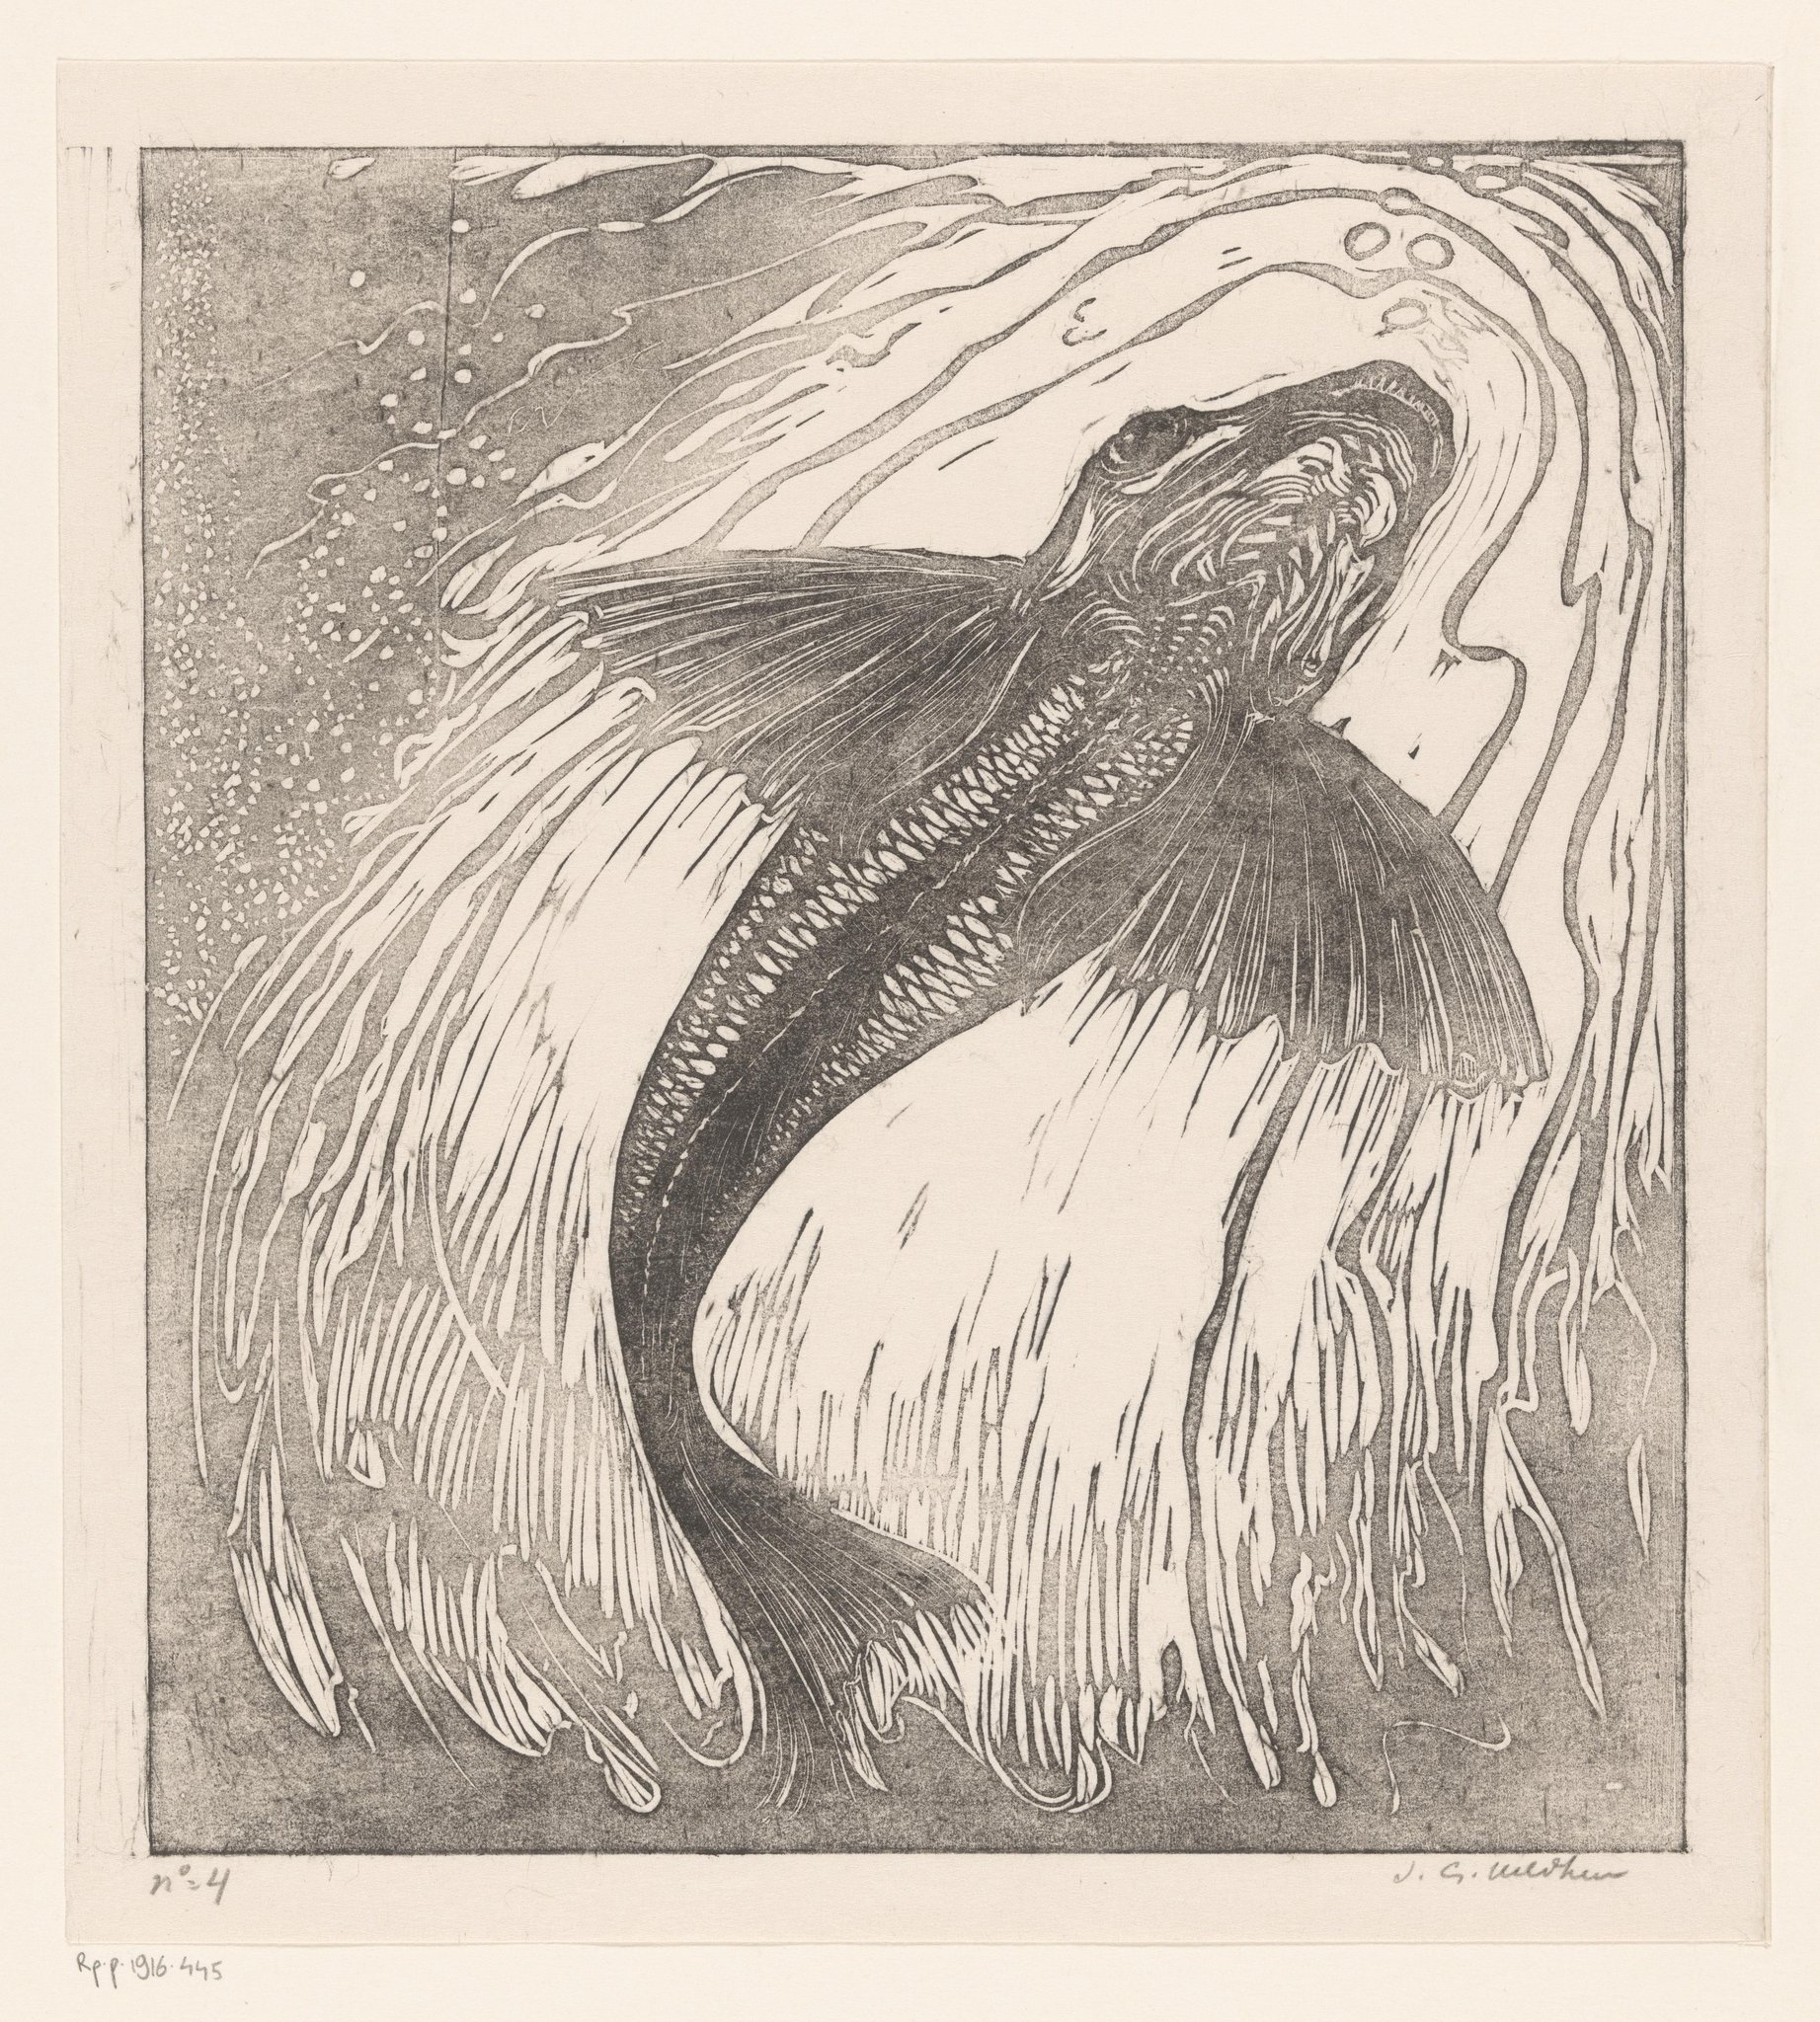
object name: print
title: Vis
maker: jacobus gerardus veldheer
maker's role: draughtsman, print maker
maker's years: 1866-1954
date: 1876-1916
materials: paper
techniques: woodcut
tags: fishes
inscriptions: collector's mark: Lugt 2233